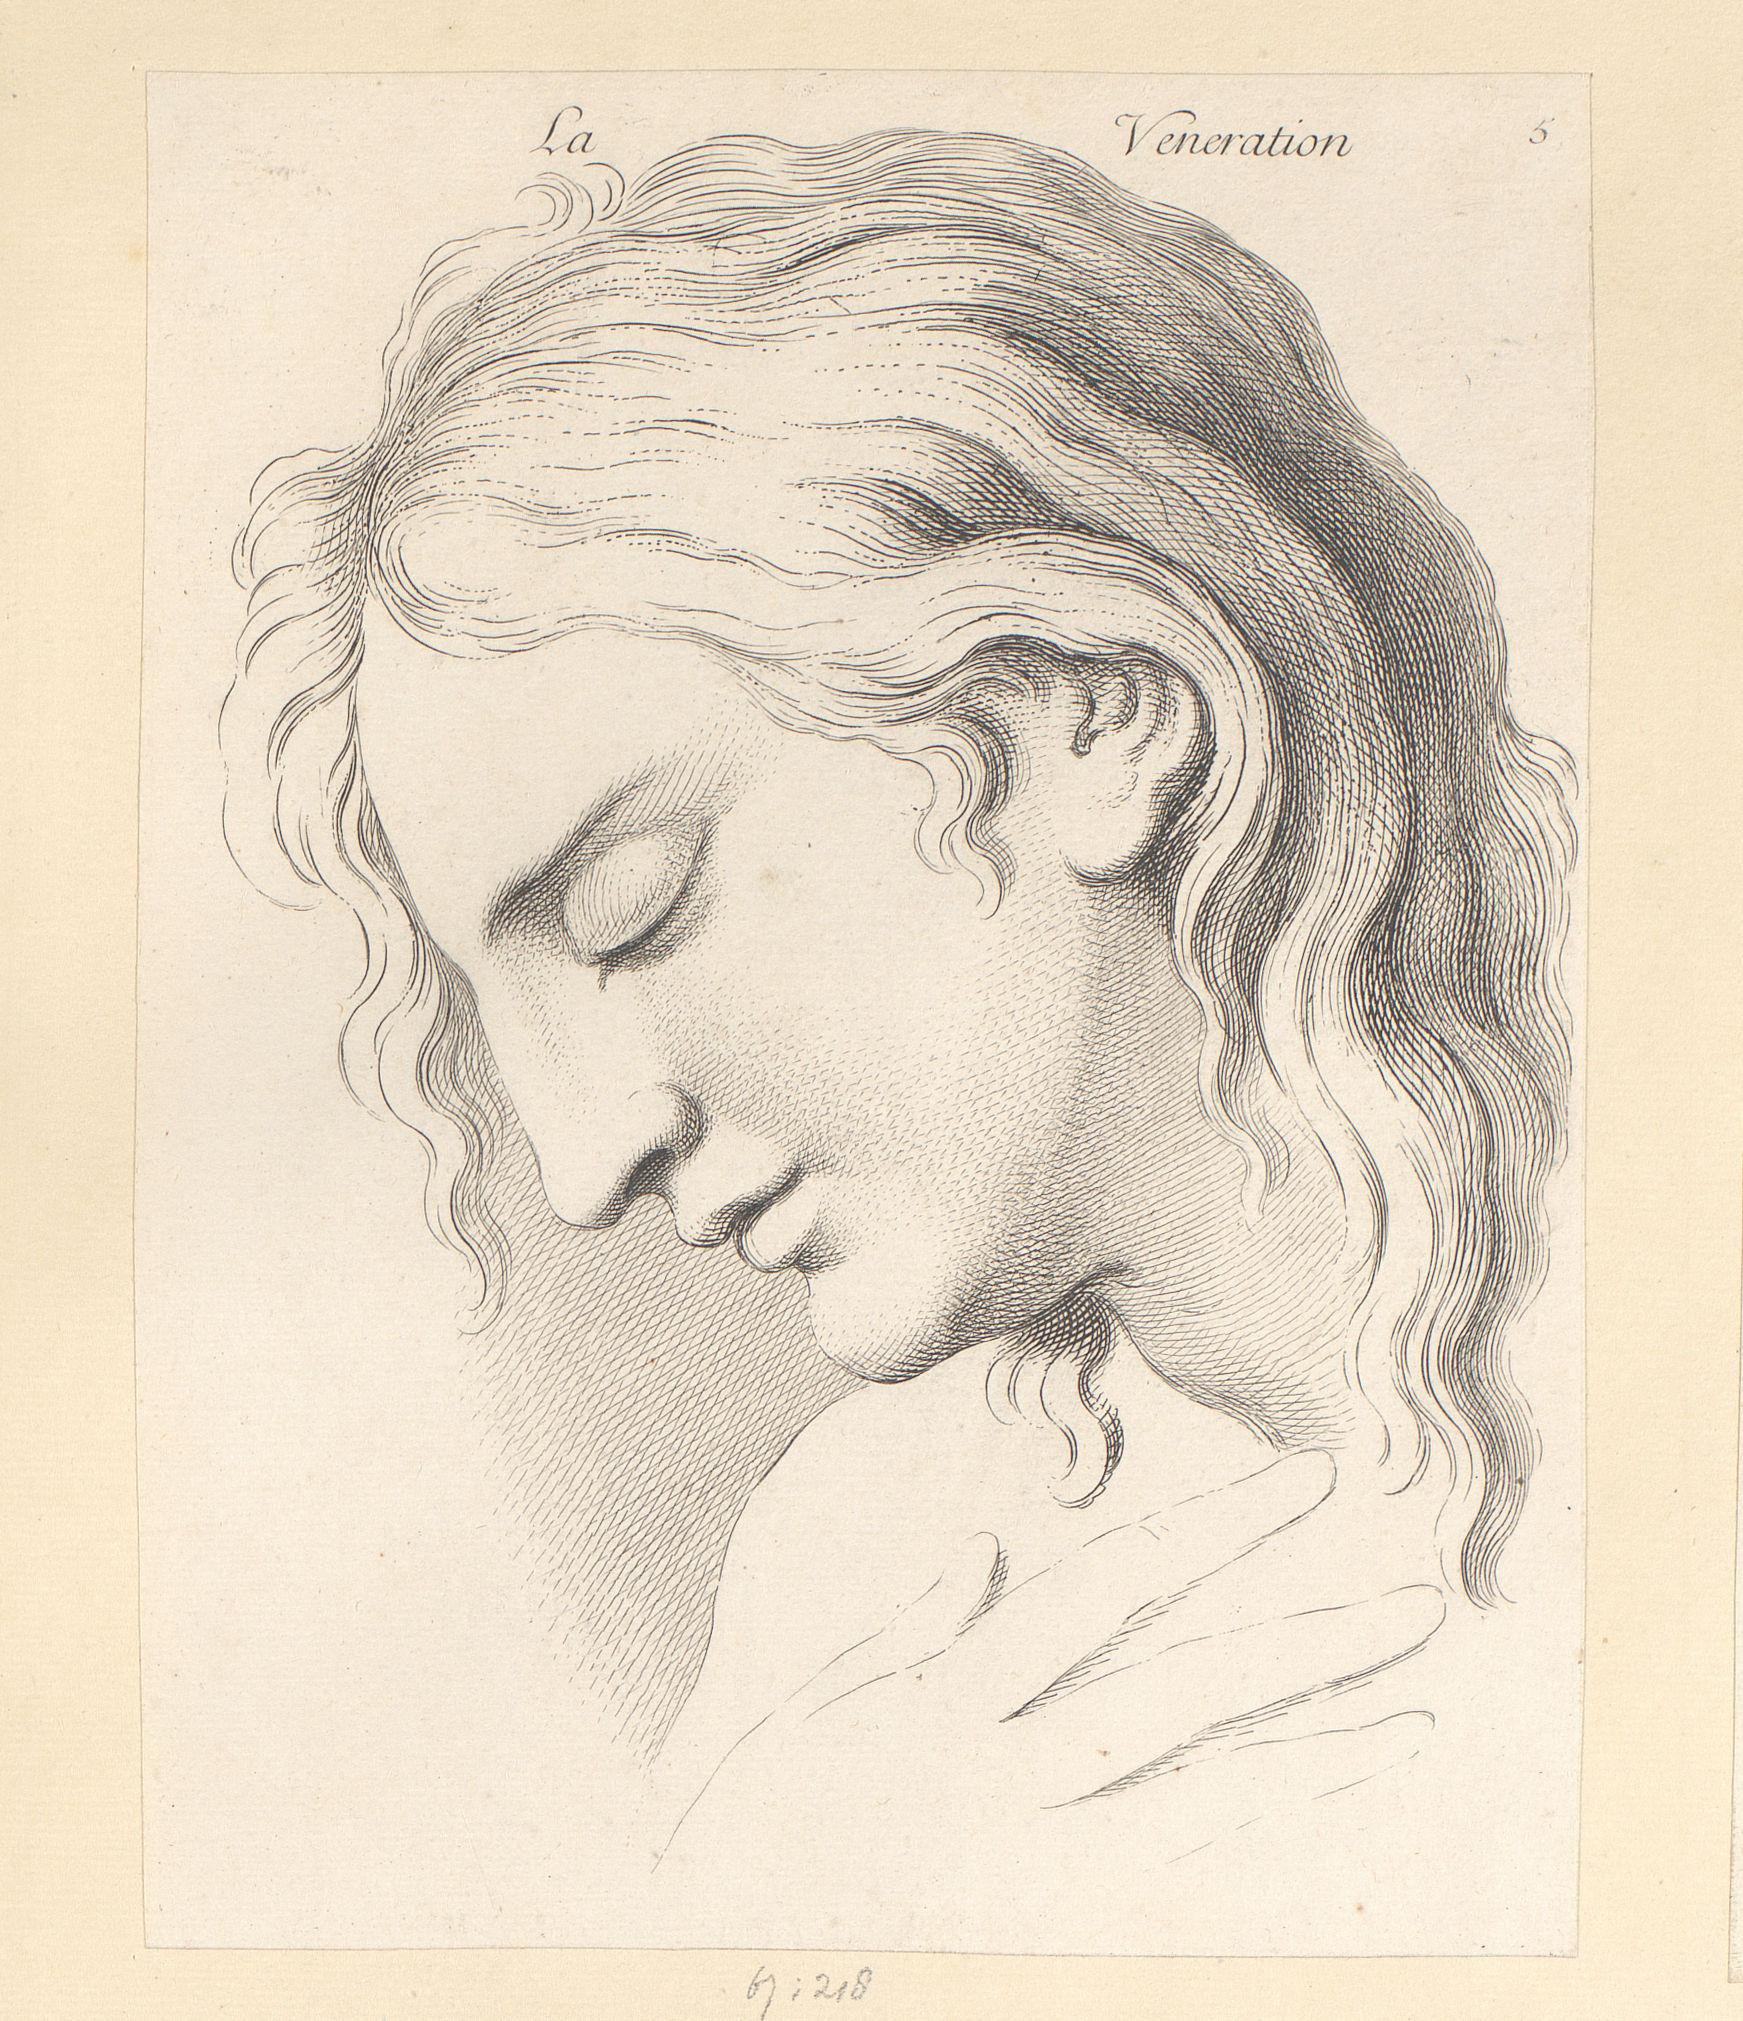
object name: album leaf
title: L'ouvrage de Charles le Brun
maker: jean audran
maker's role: print maker, publisher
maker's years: 1667-1756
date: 1727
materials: paper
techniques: engraving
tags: face, devotion, piety; 'divotione' (ripa), morphology of facial expression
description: Prent uit: Le Brun, Charles. Expressions des Passions de l'Ame. Representées en plusieurs testes gravées d'apres les desseins de feu Monsieur le Brun, Premier Peintre du Roy. Parijs: Jean Audran, 1727. Reeks van 19 portretten, een titelprent en twee (dubbelzijdig bedrukte) bladen tekst.